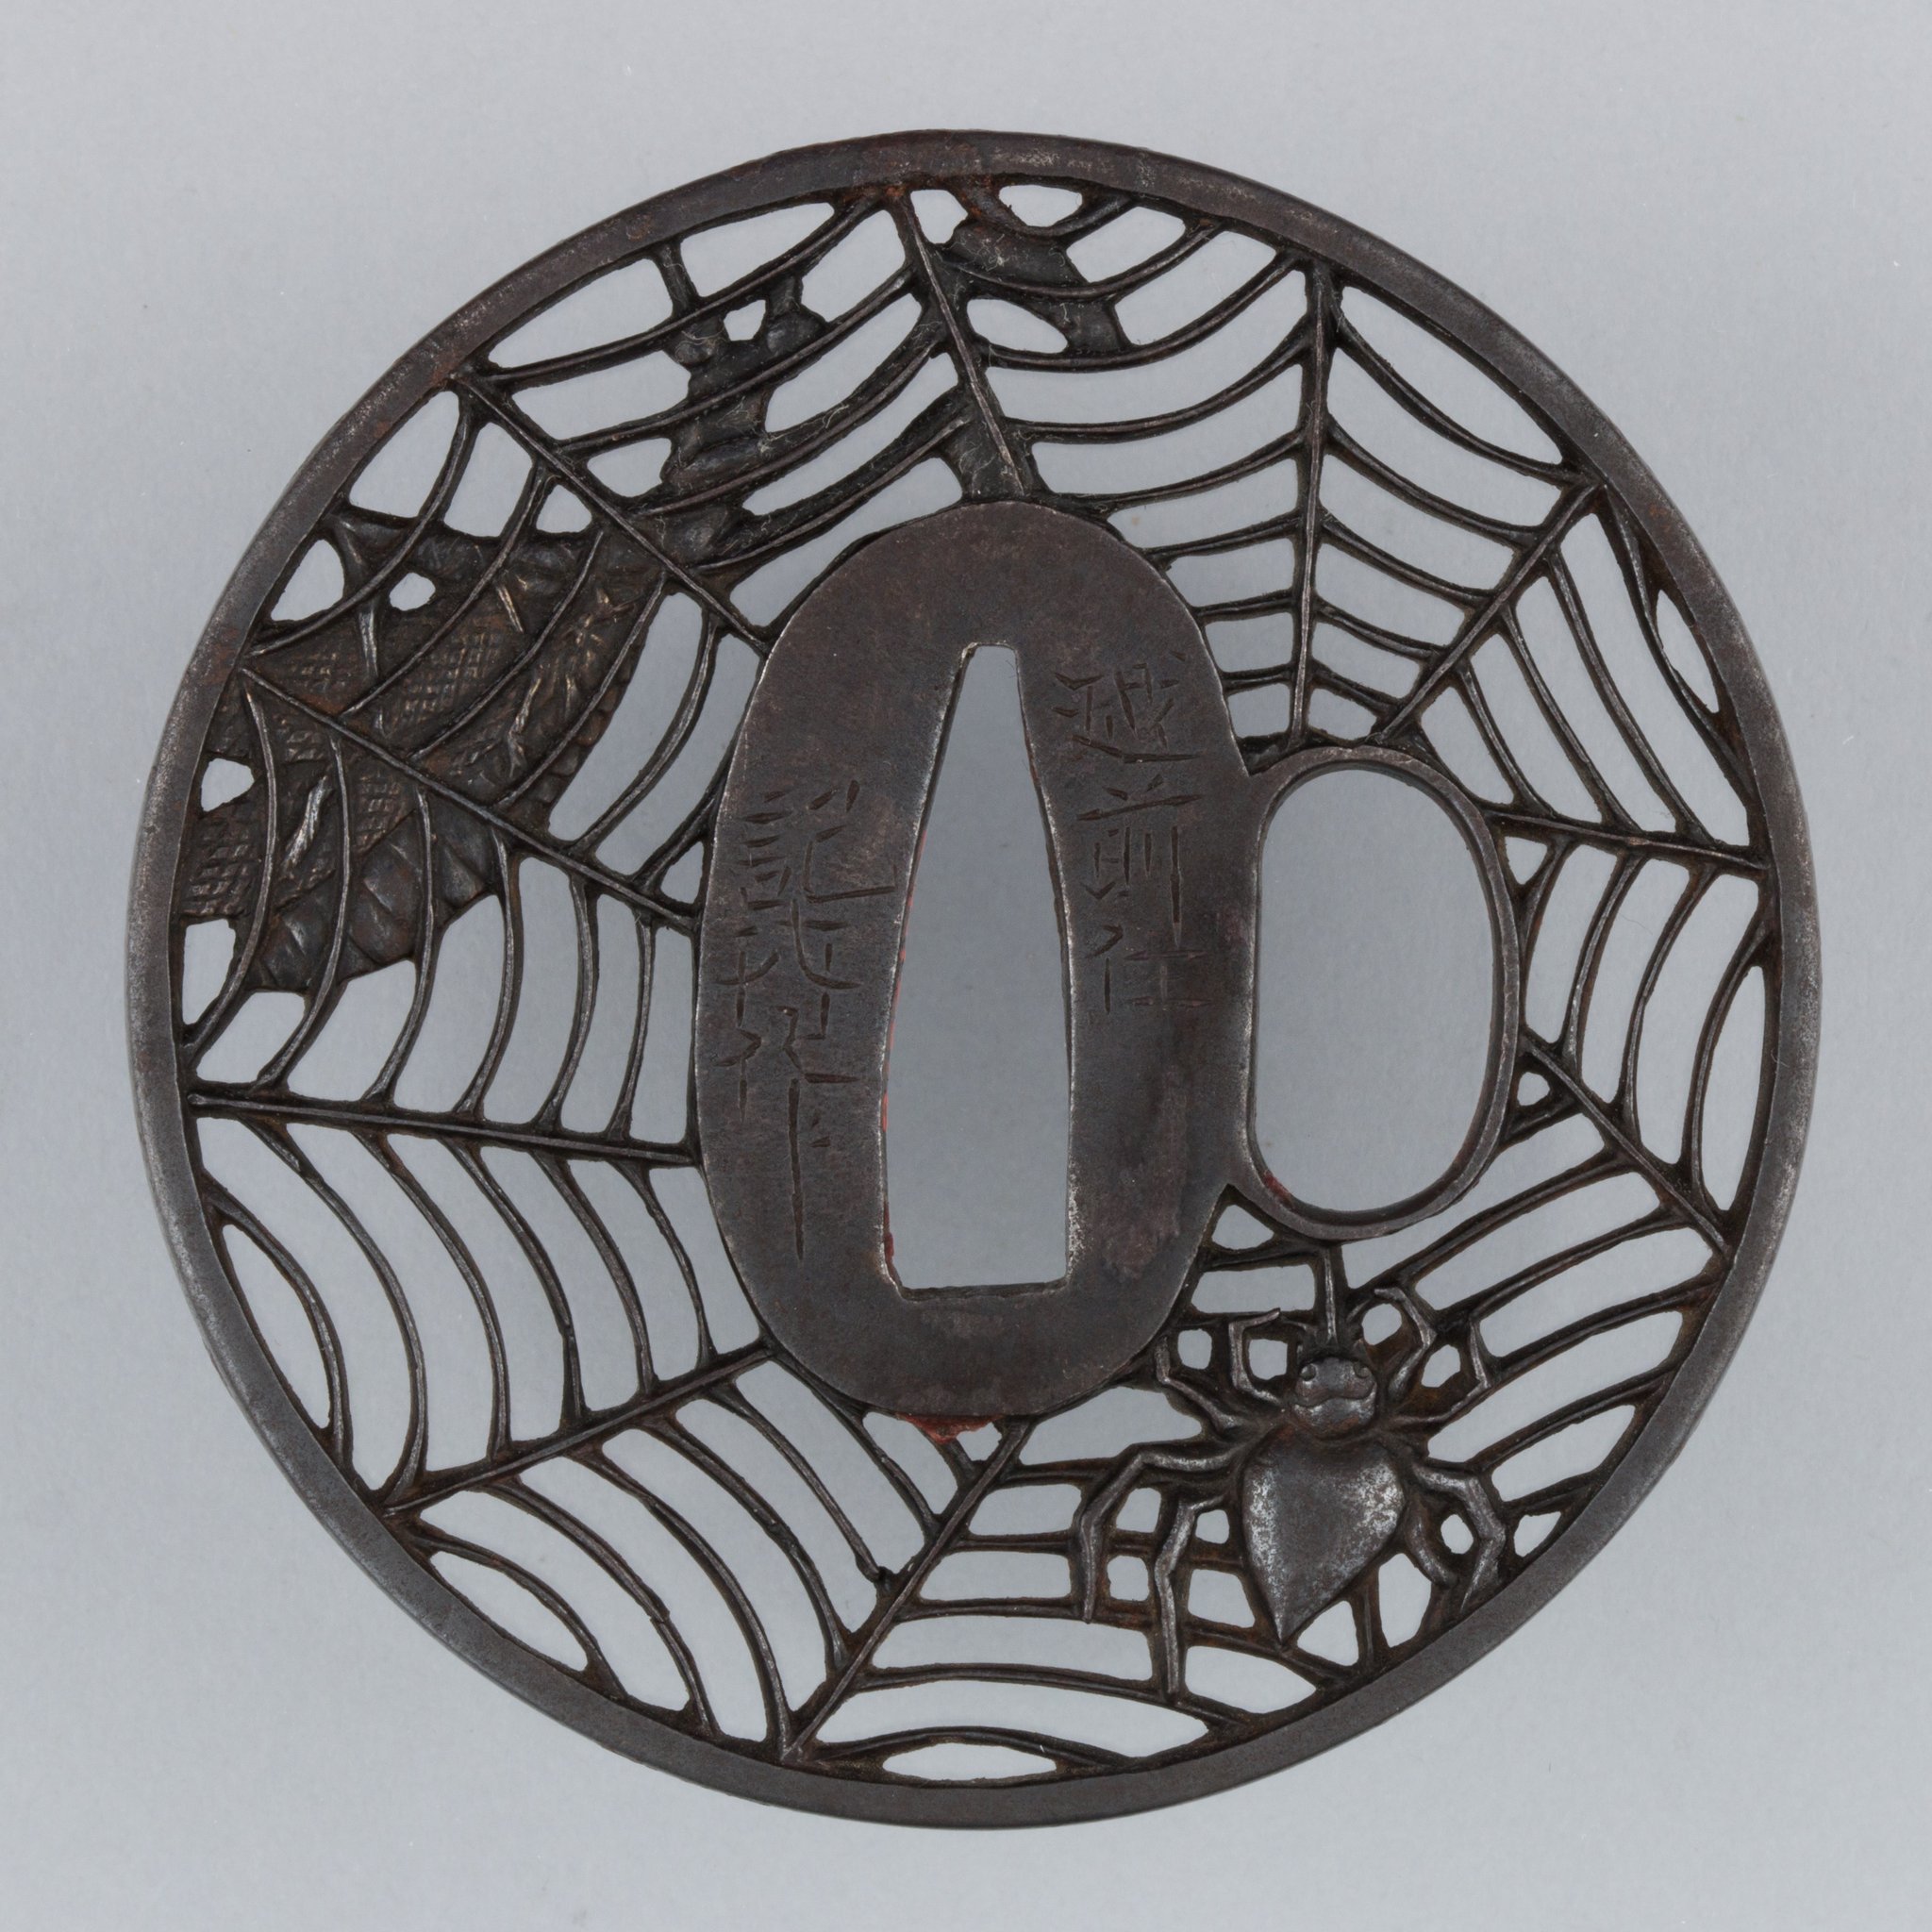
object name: sword guard tsuba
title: Sword Guard (Tsuba)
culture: japanese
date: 1701-1800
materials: copper, iron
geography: japan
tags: spiders